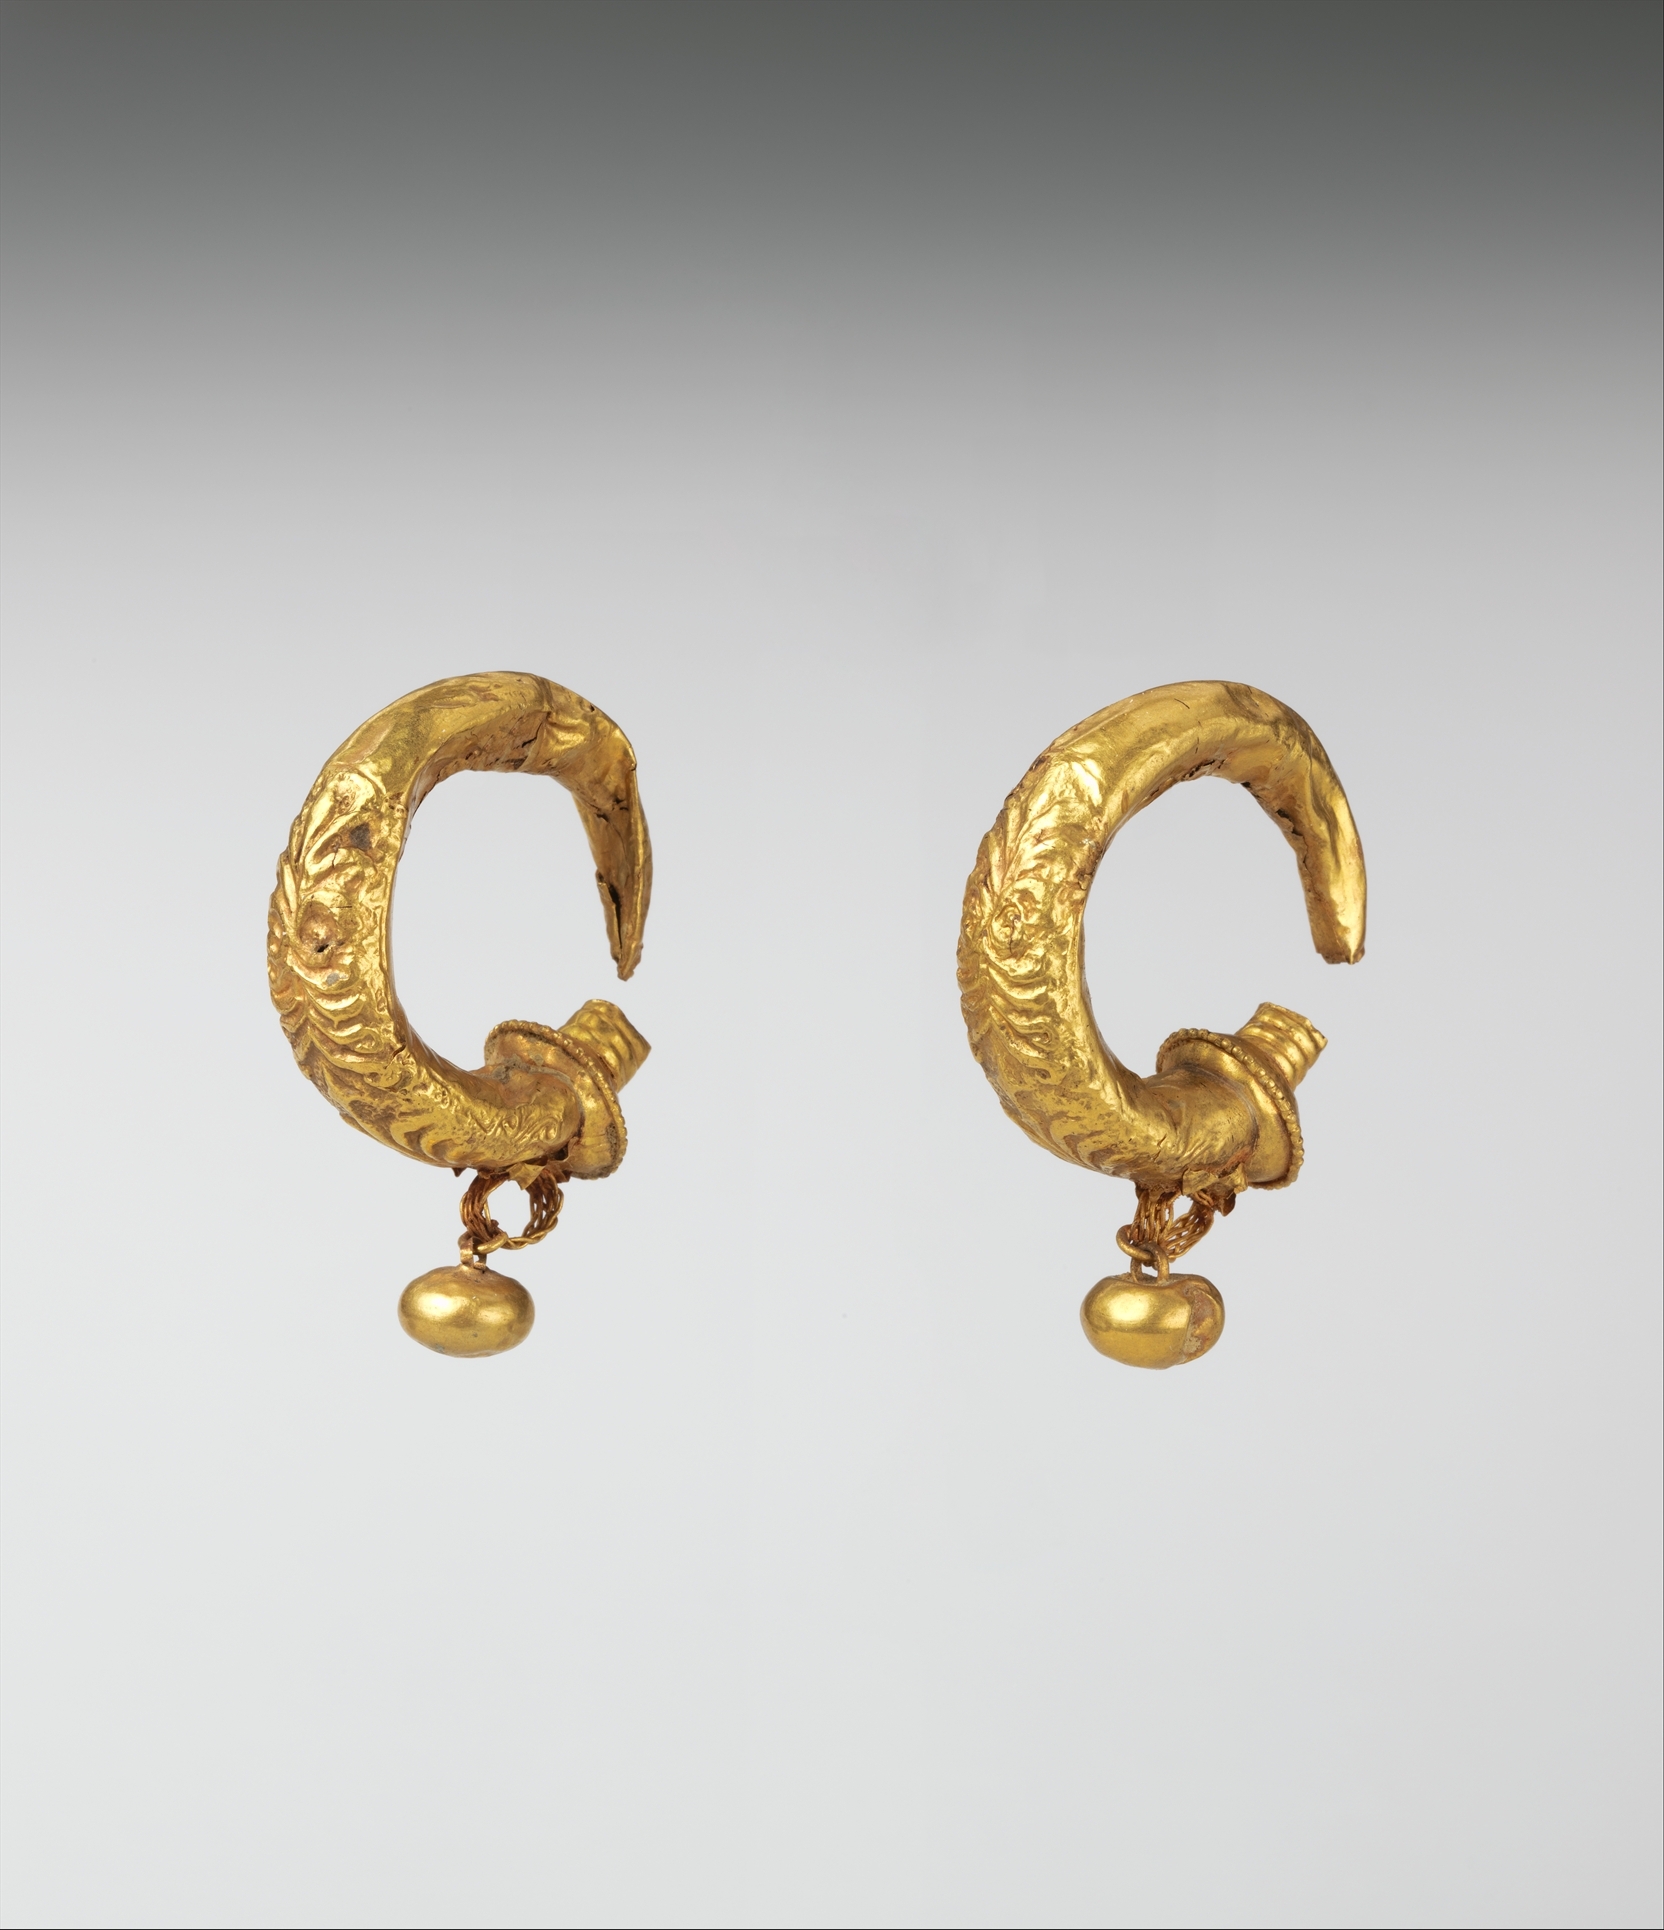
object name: earring, trumpet shaped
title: Gold earrings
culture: etruscan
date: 400-201 BCE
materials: gold